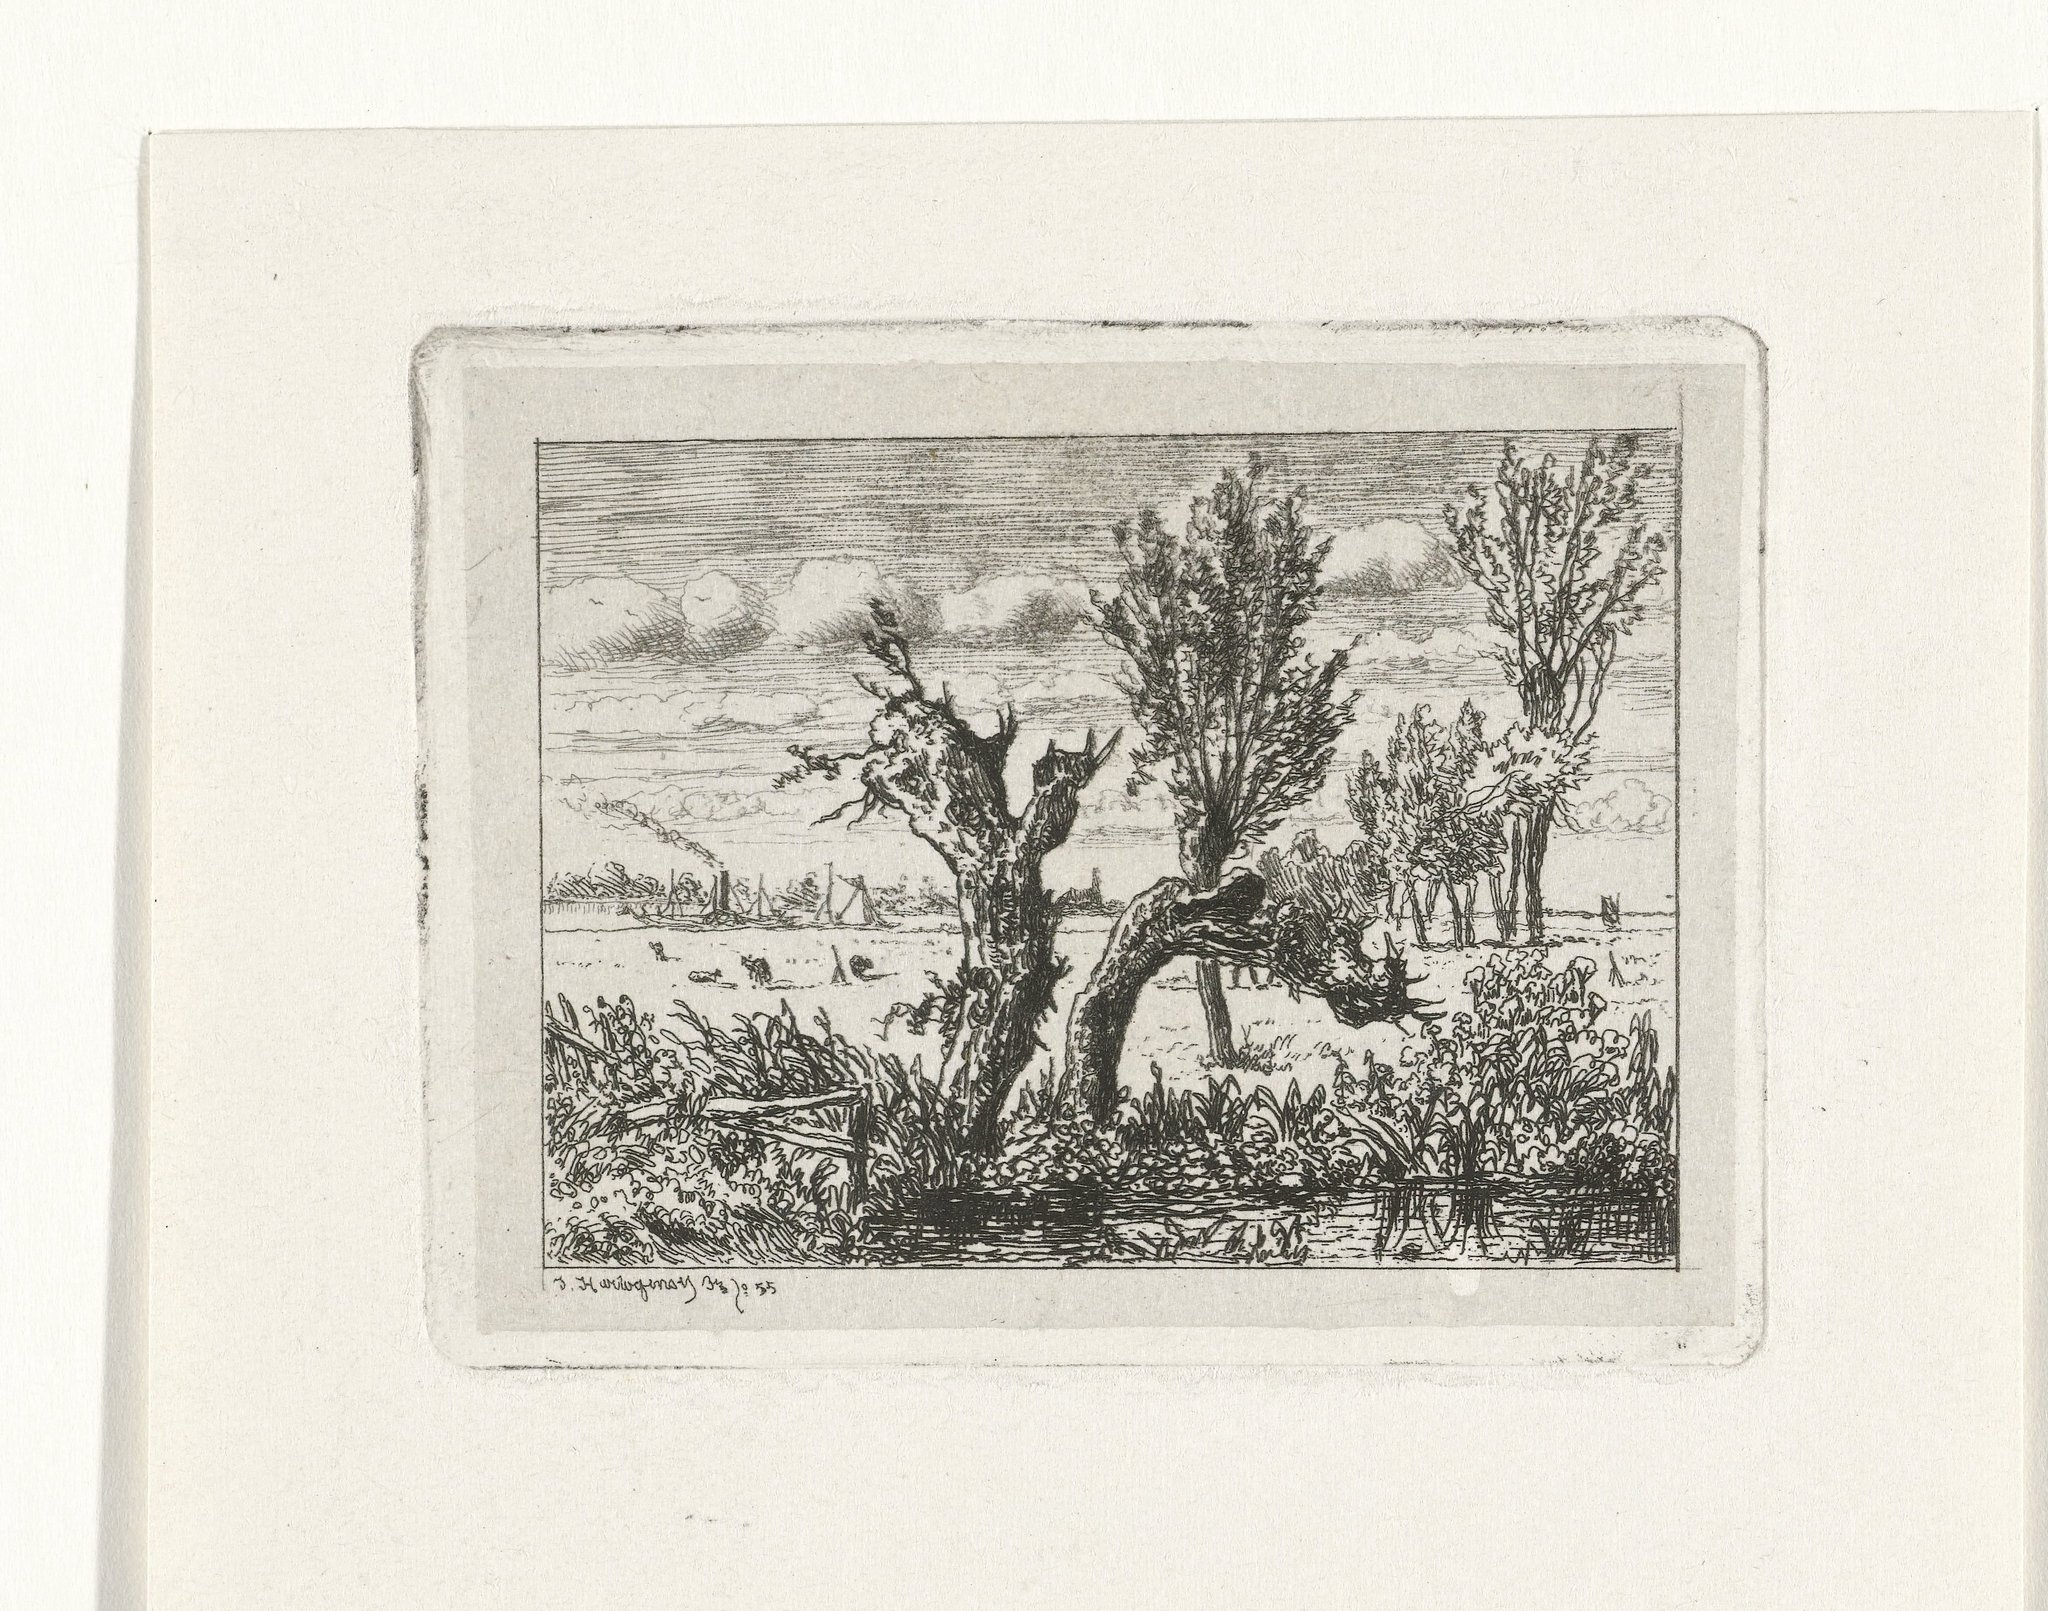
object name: print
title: Landschap met knotwilgen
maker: joseph hartogensis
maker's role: painter, print maker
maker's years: 1822-1865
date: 1855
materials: paper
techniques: etching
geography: the hague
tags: landscapes with waters, waterscapes, seascapes (in the temperate zone), trees: willow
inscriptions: collector's mark: Lugt 2228